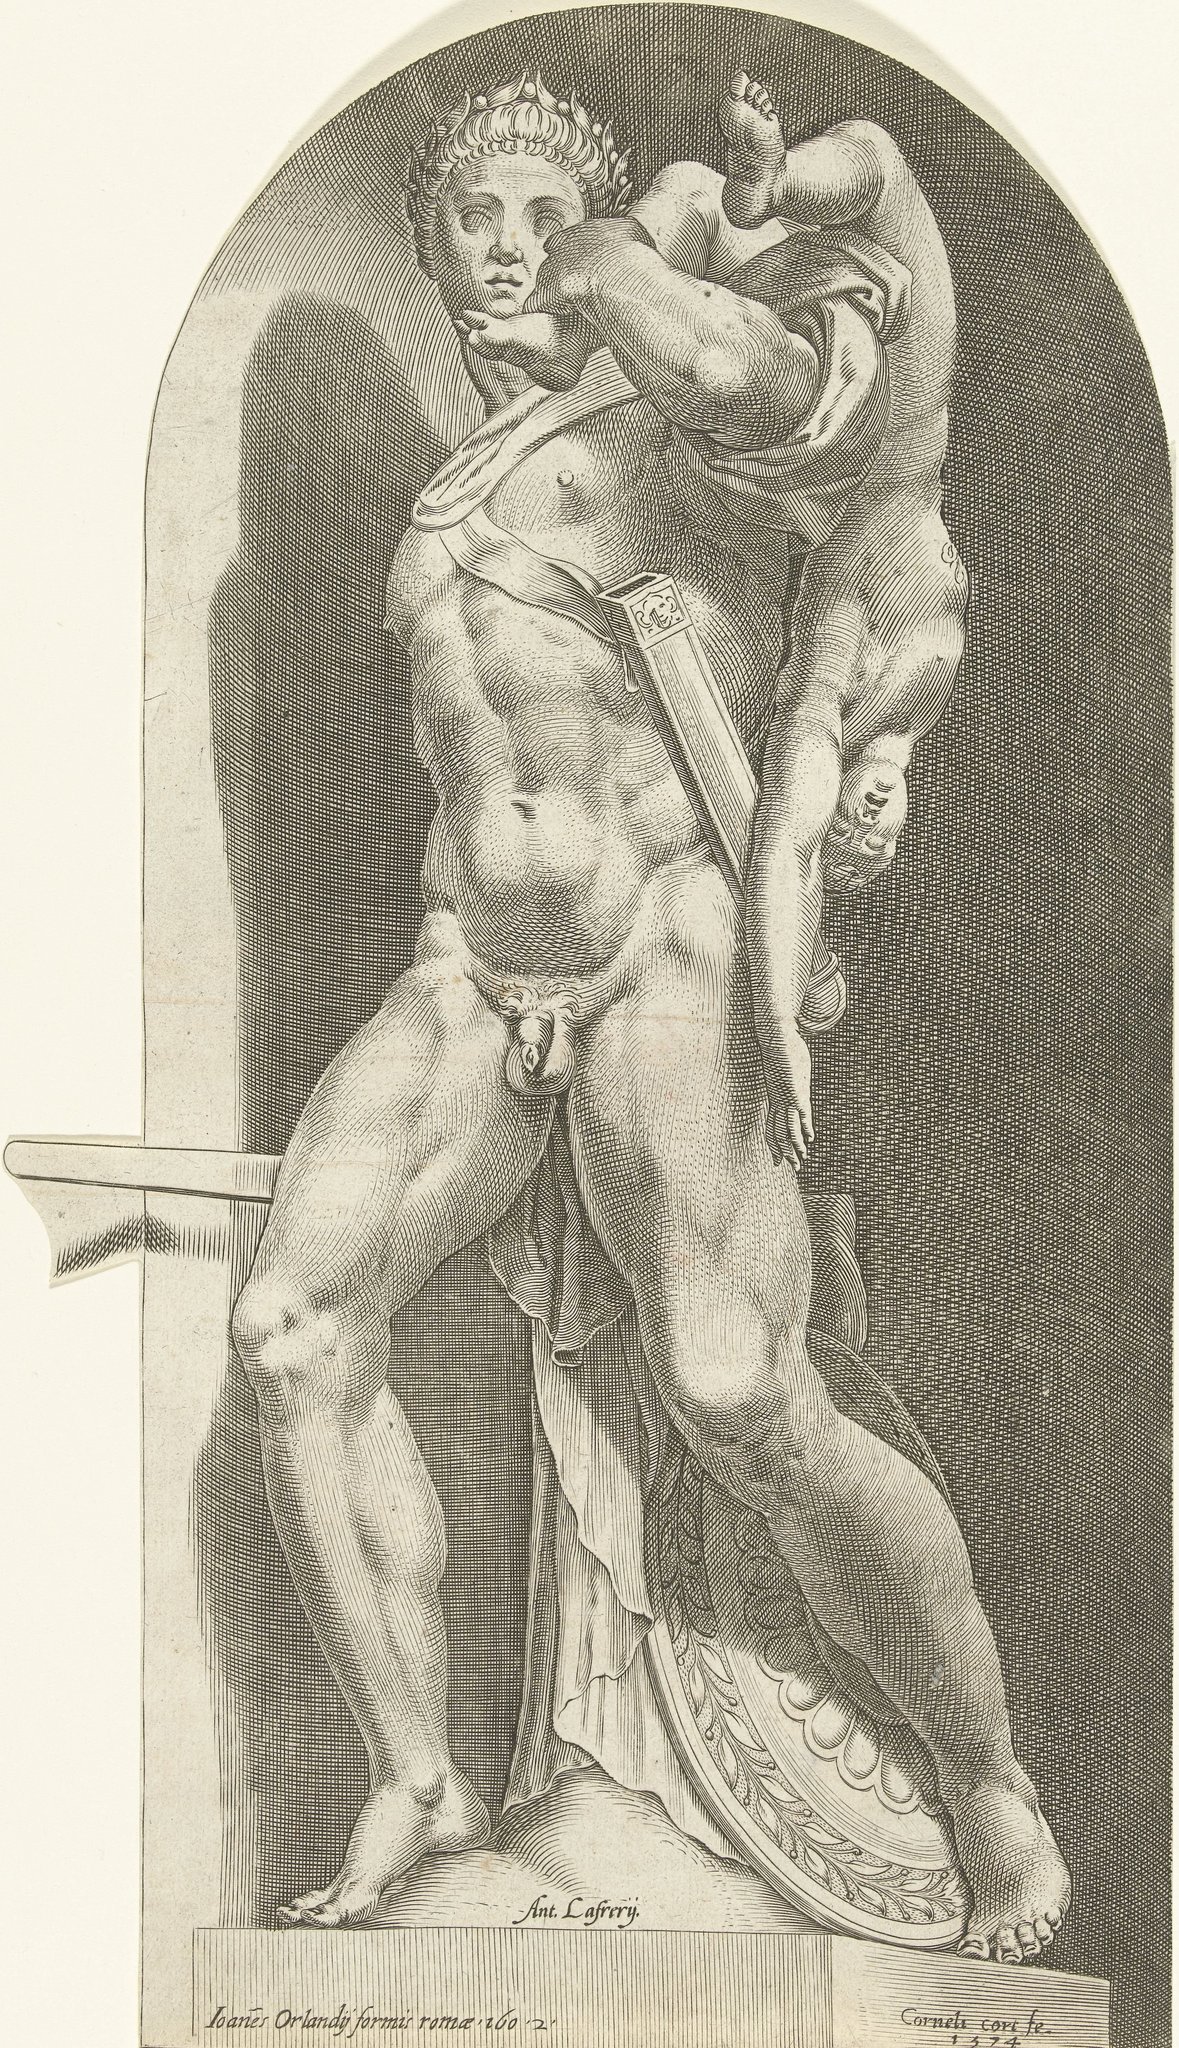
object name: print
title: Beeld van een naakte krijgsman met het lichaam van een dood kind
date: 1574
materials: paper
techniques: engraving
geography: rome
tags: death of a child, piece of sculpture, reproduction of a piece of sculpture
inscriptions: collector's mark: Lugt 2166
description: Beeld van een naakte krijgsman met zwaard en het lichaam van een dood kind over de schouder, staand in een nis.